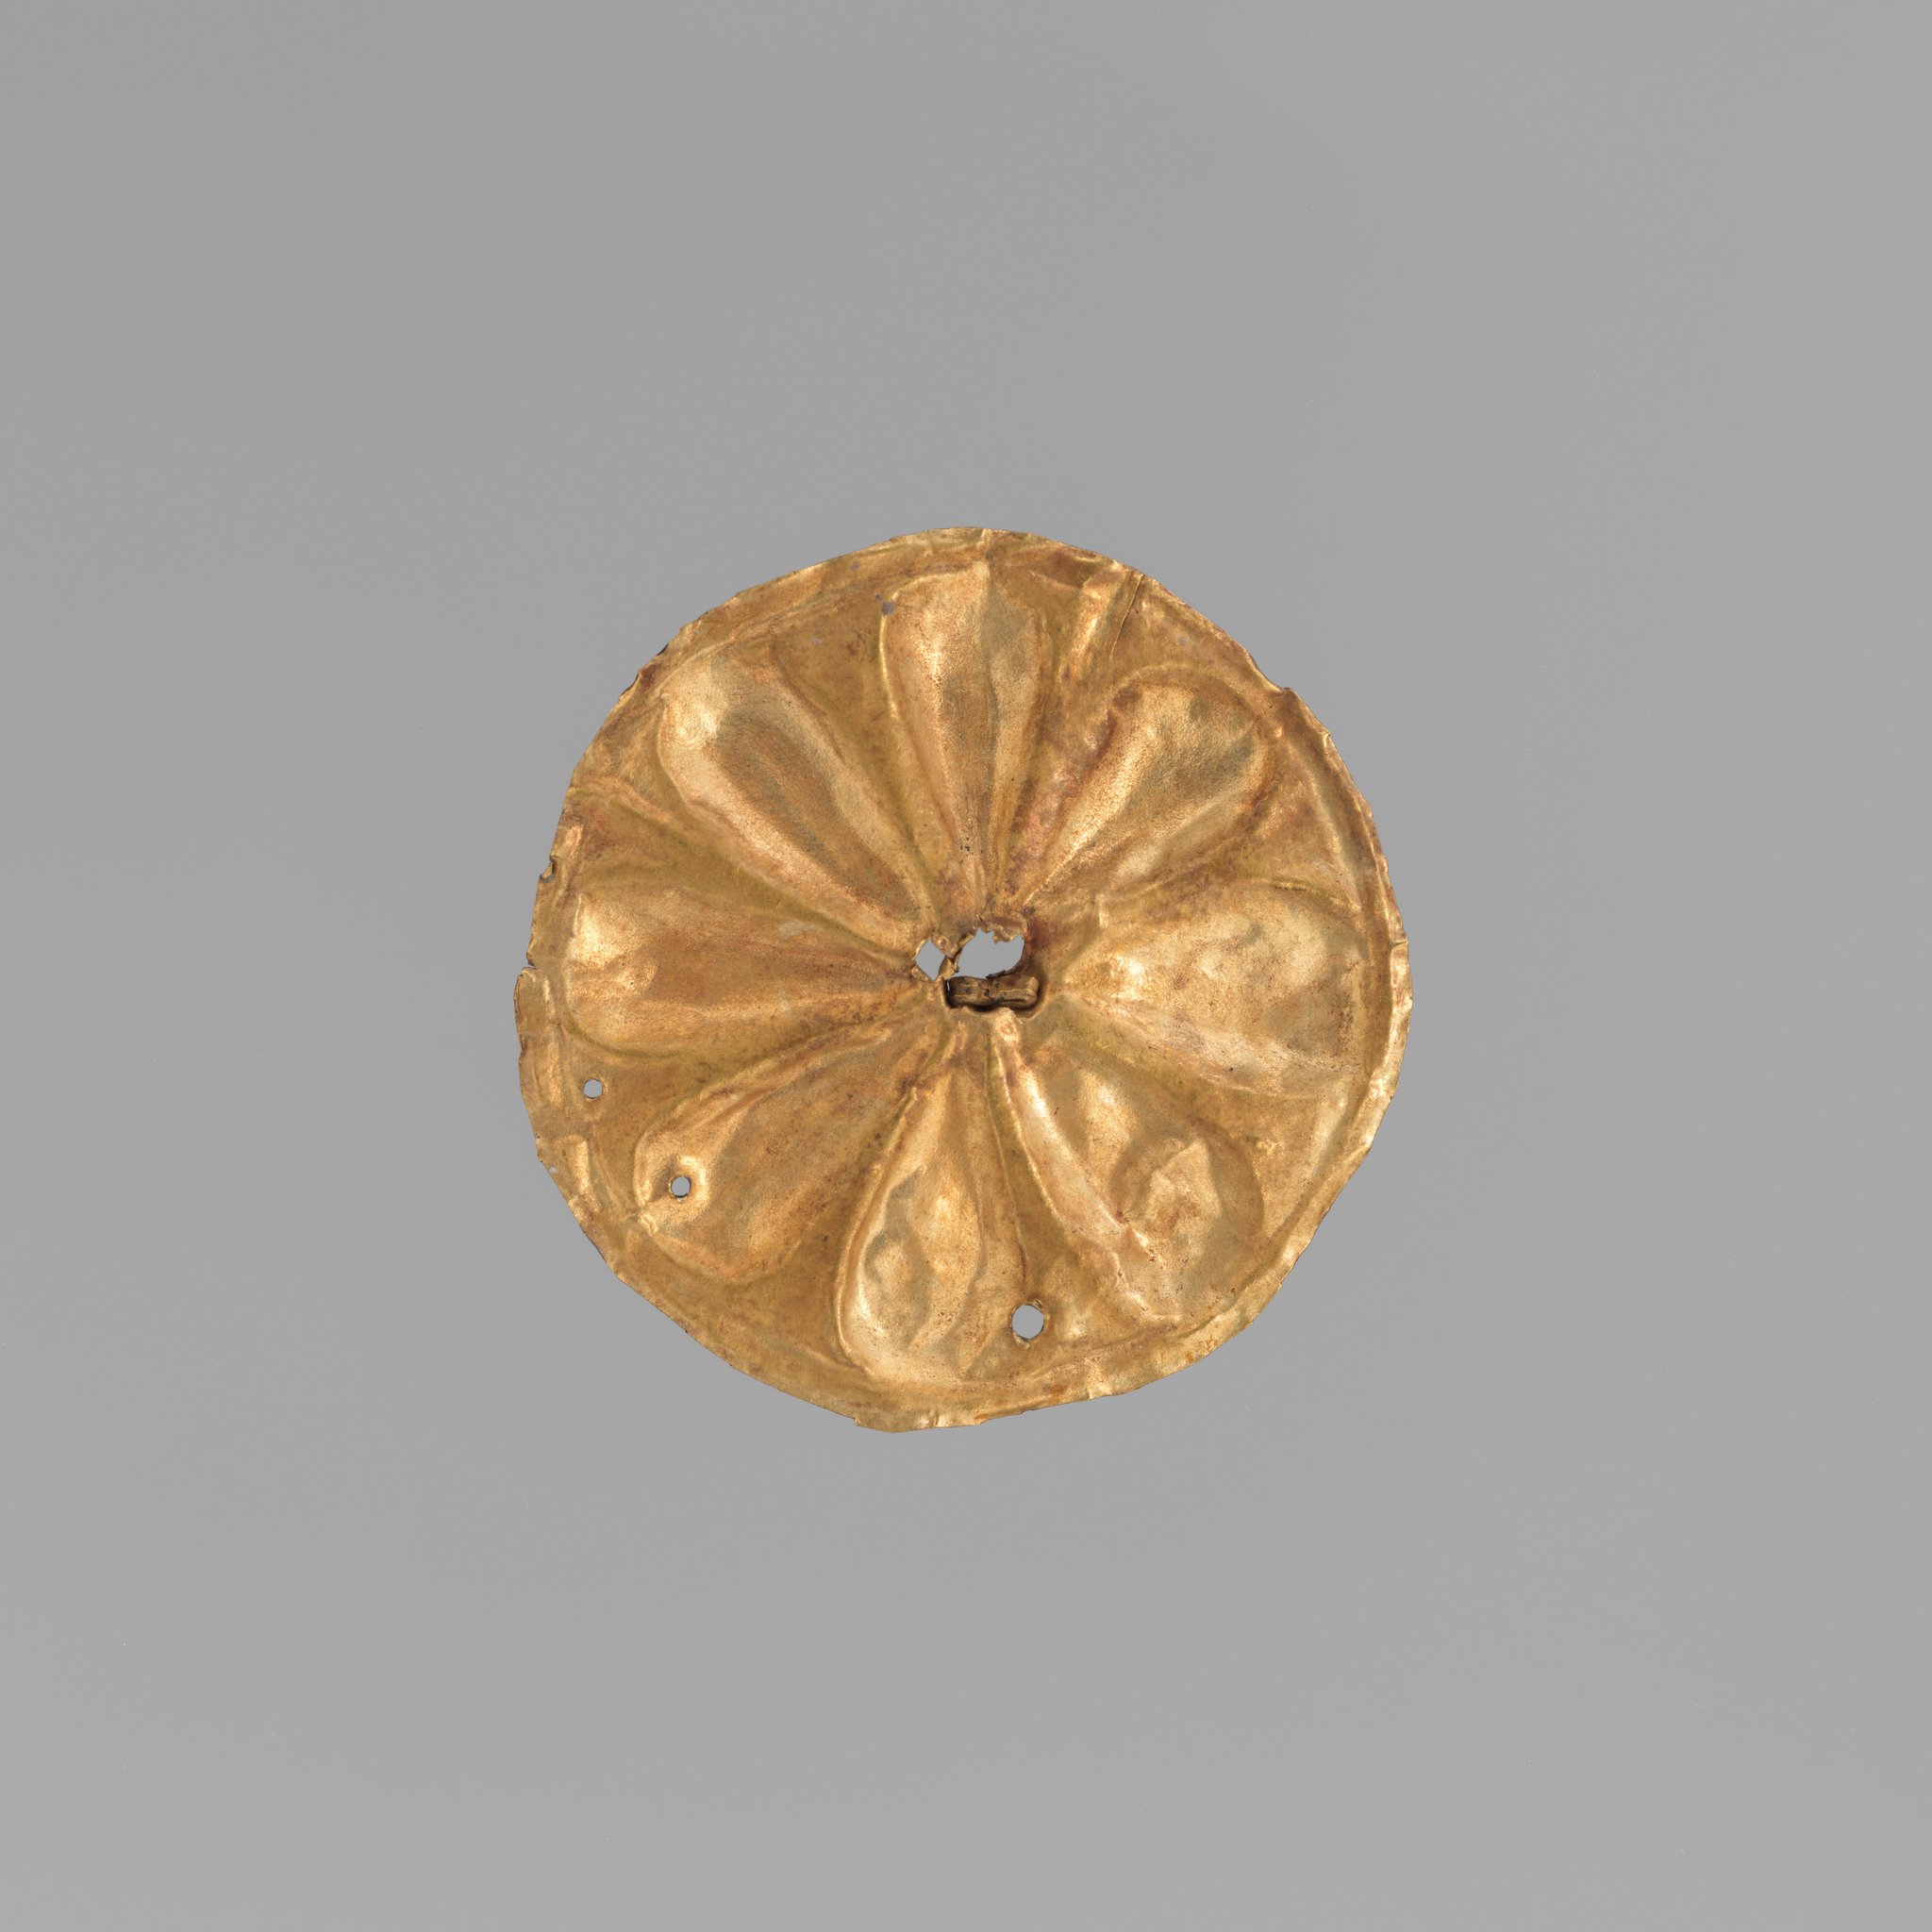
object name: roundel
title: Gold roundel with stamped designs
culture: cypriot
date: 1600-1050 BCE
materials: gold